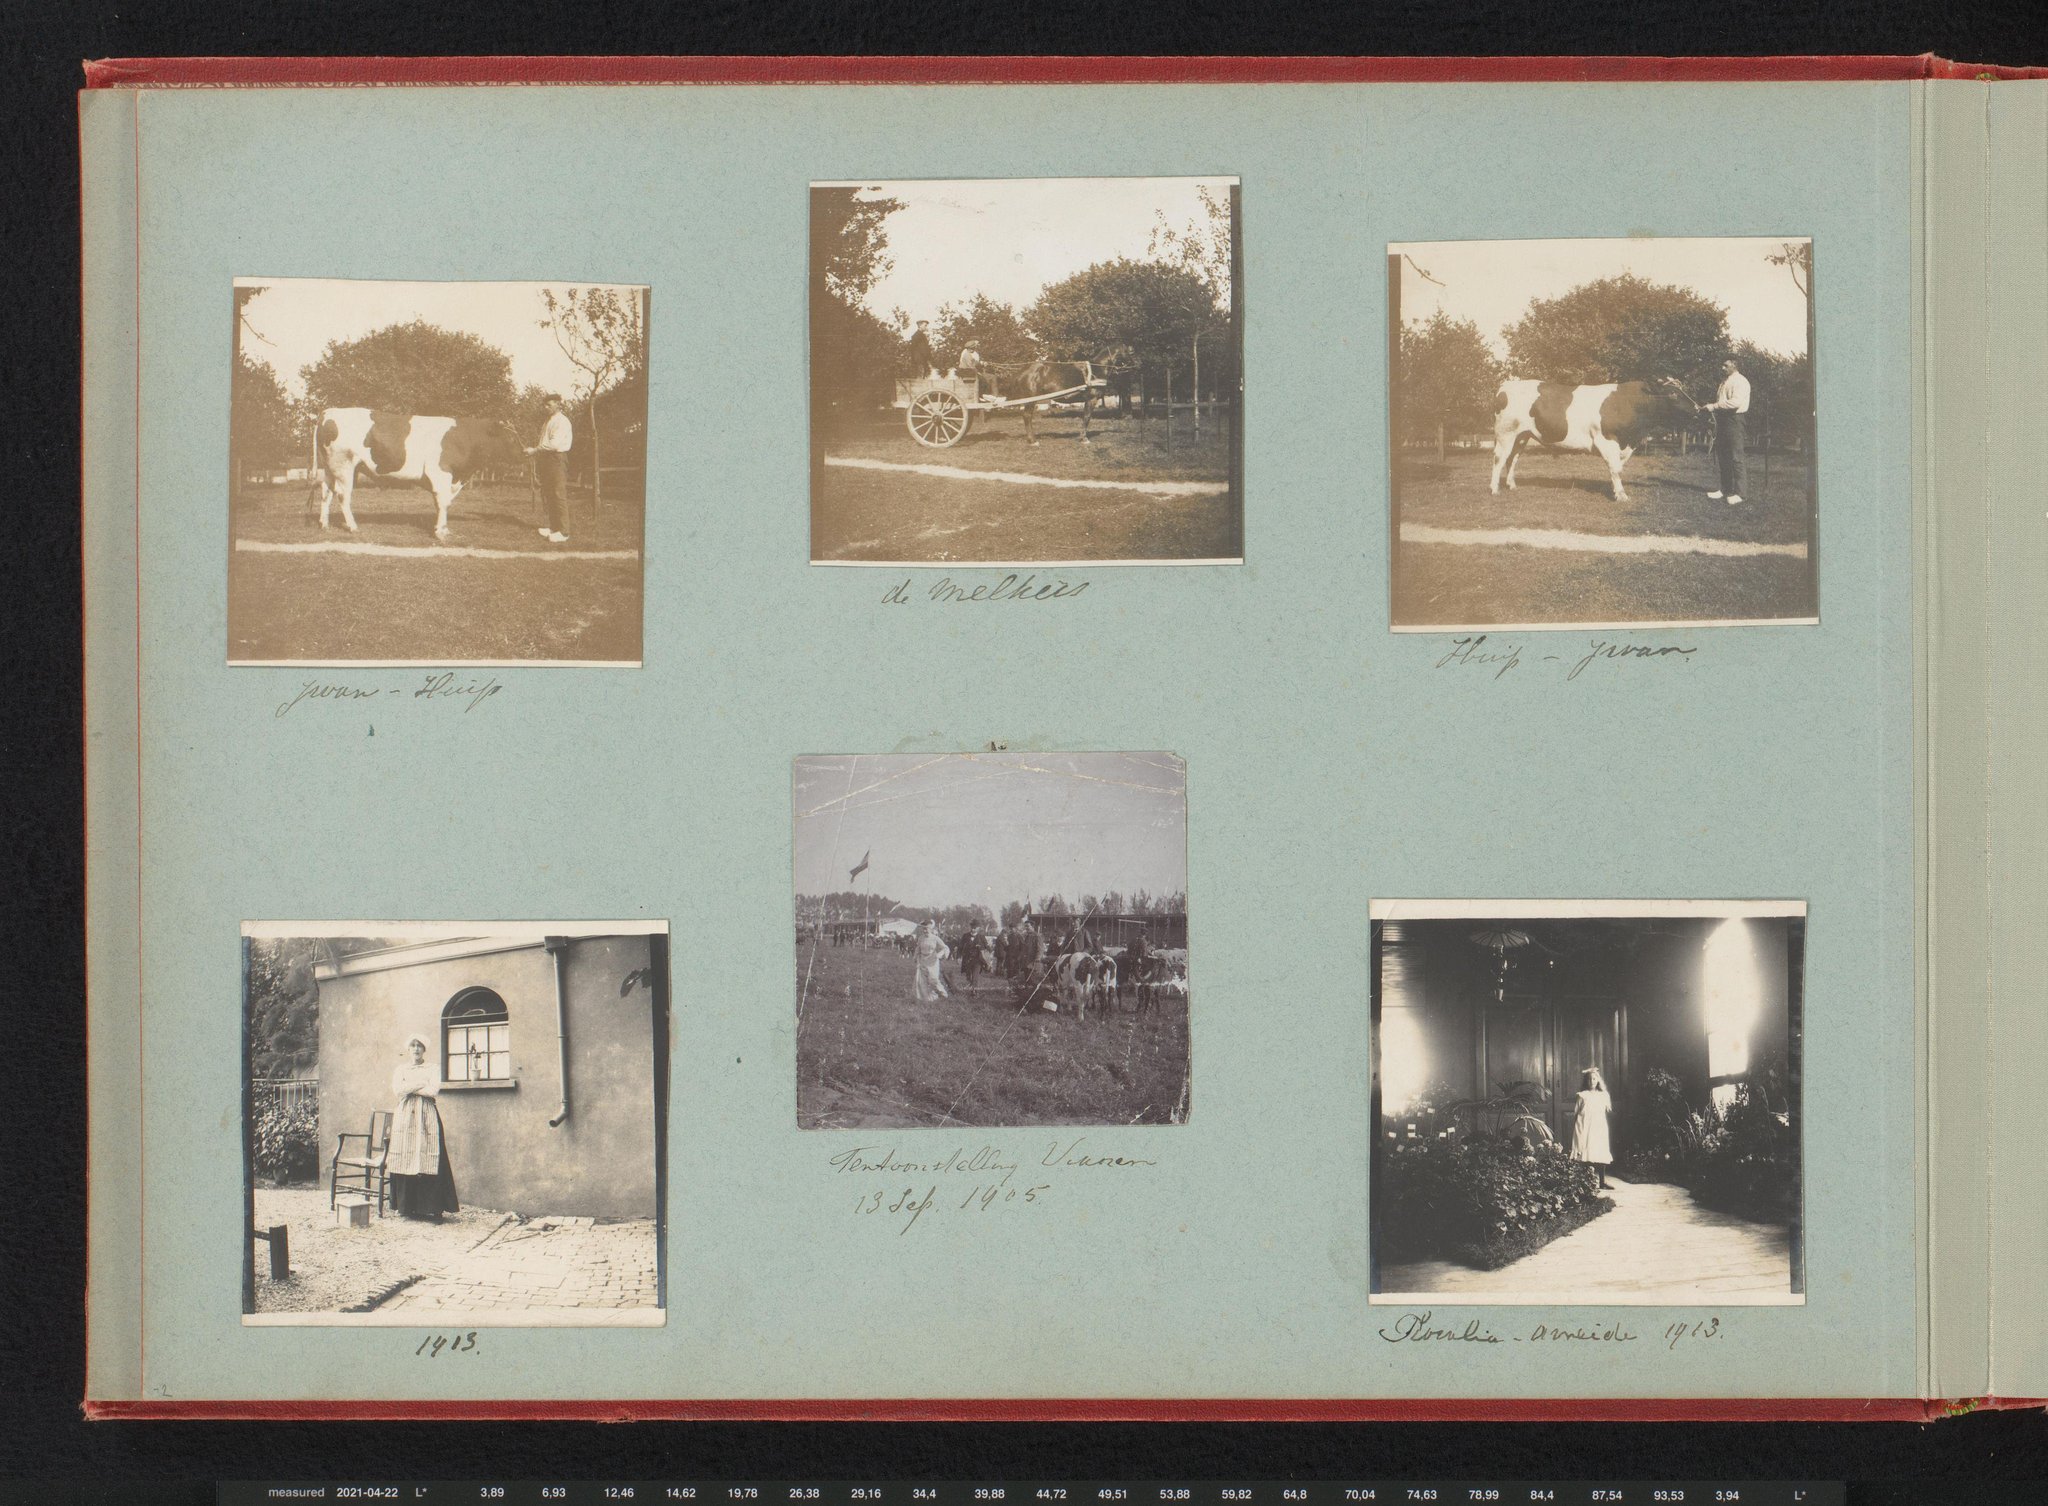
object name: photograph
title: Gezicht op een landbouwtentoonstelling in Vianen, een koe met melkboeren, en een vrouw en een meisje op een boerderij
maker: Anonymous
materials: paper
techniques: gelatin silver print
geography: netherlands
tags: cow, cattle-breeding, livestock industry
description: Deze foto's zijn onderdeel van een album.